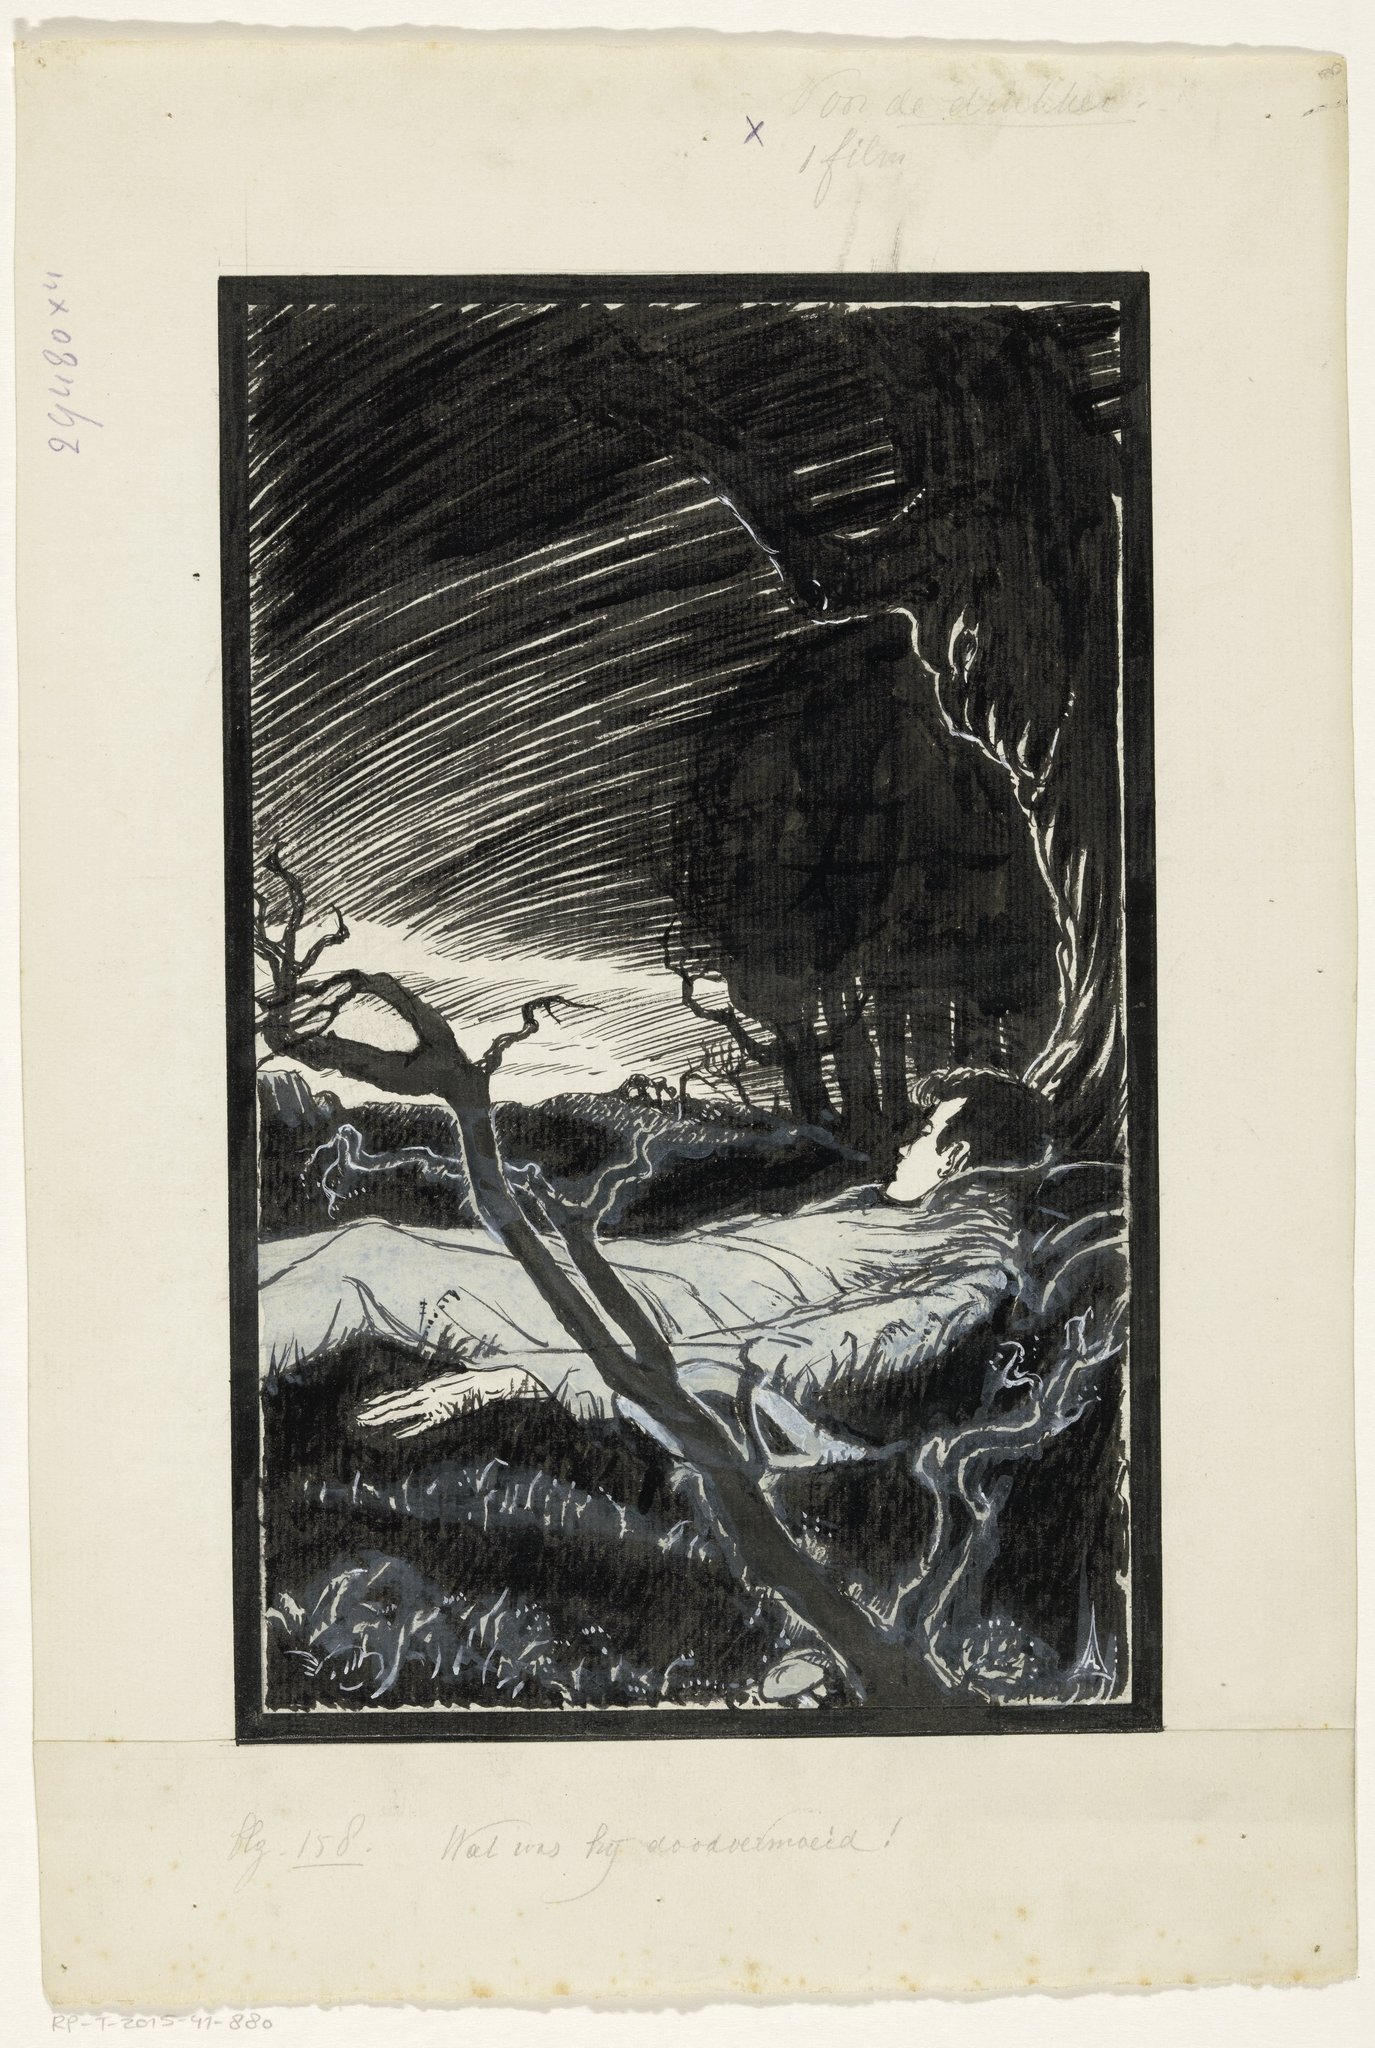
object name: drawing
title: Willem slaapt in een landschap bij nacht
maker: anny leusink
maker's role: draughtsman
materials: paint, ink, paper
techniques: brush, pen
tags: trees, going to sleep - bb - out of doors, darkness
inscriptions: collector's mark: Lugt 2228, monogram:, :, annotation: ‘blz 158. Wat was hij doodvermoeid!’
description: Ontwerp voor: Ulehake, L.A.B. Terechtgekomen. Amsterdam: Veen, 1926.